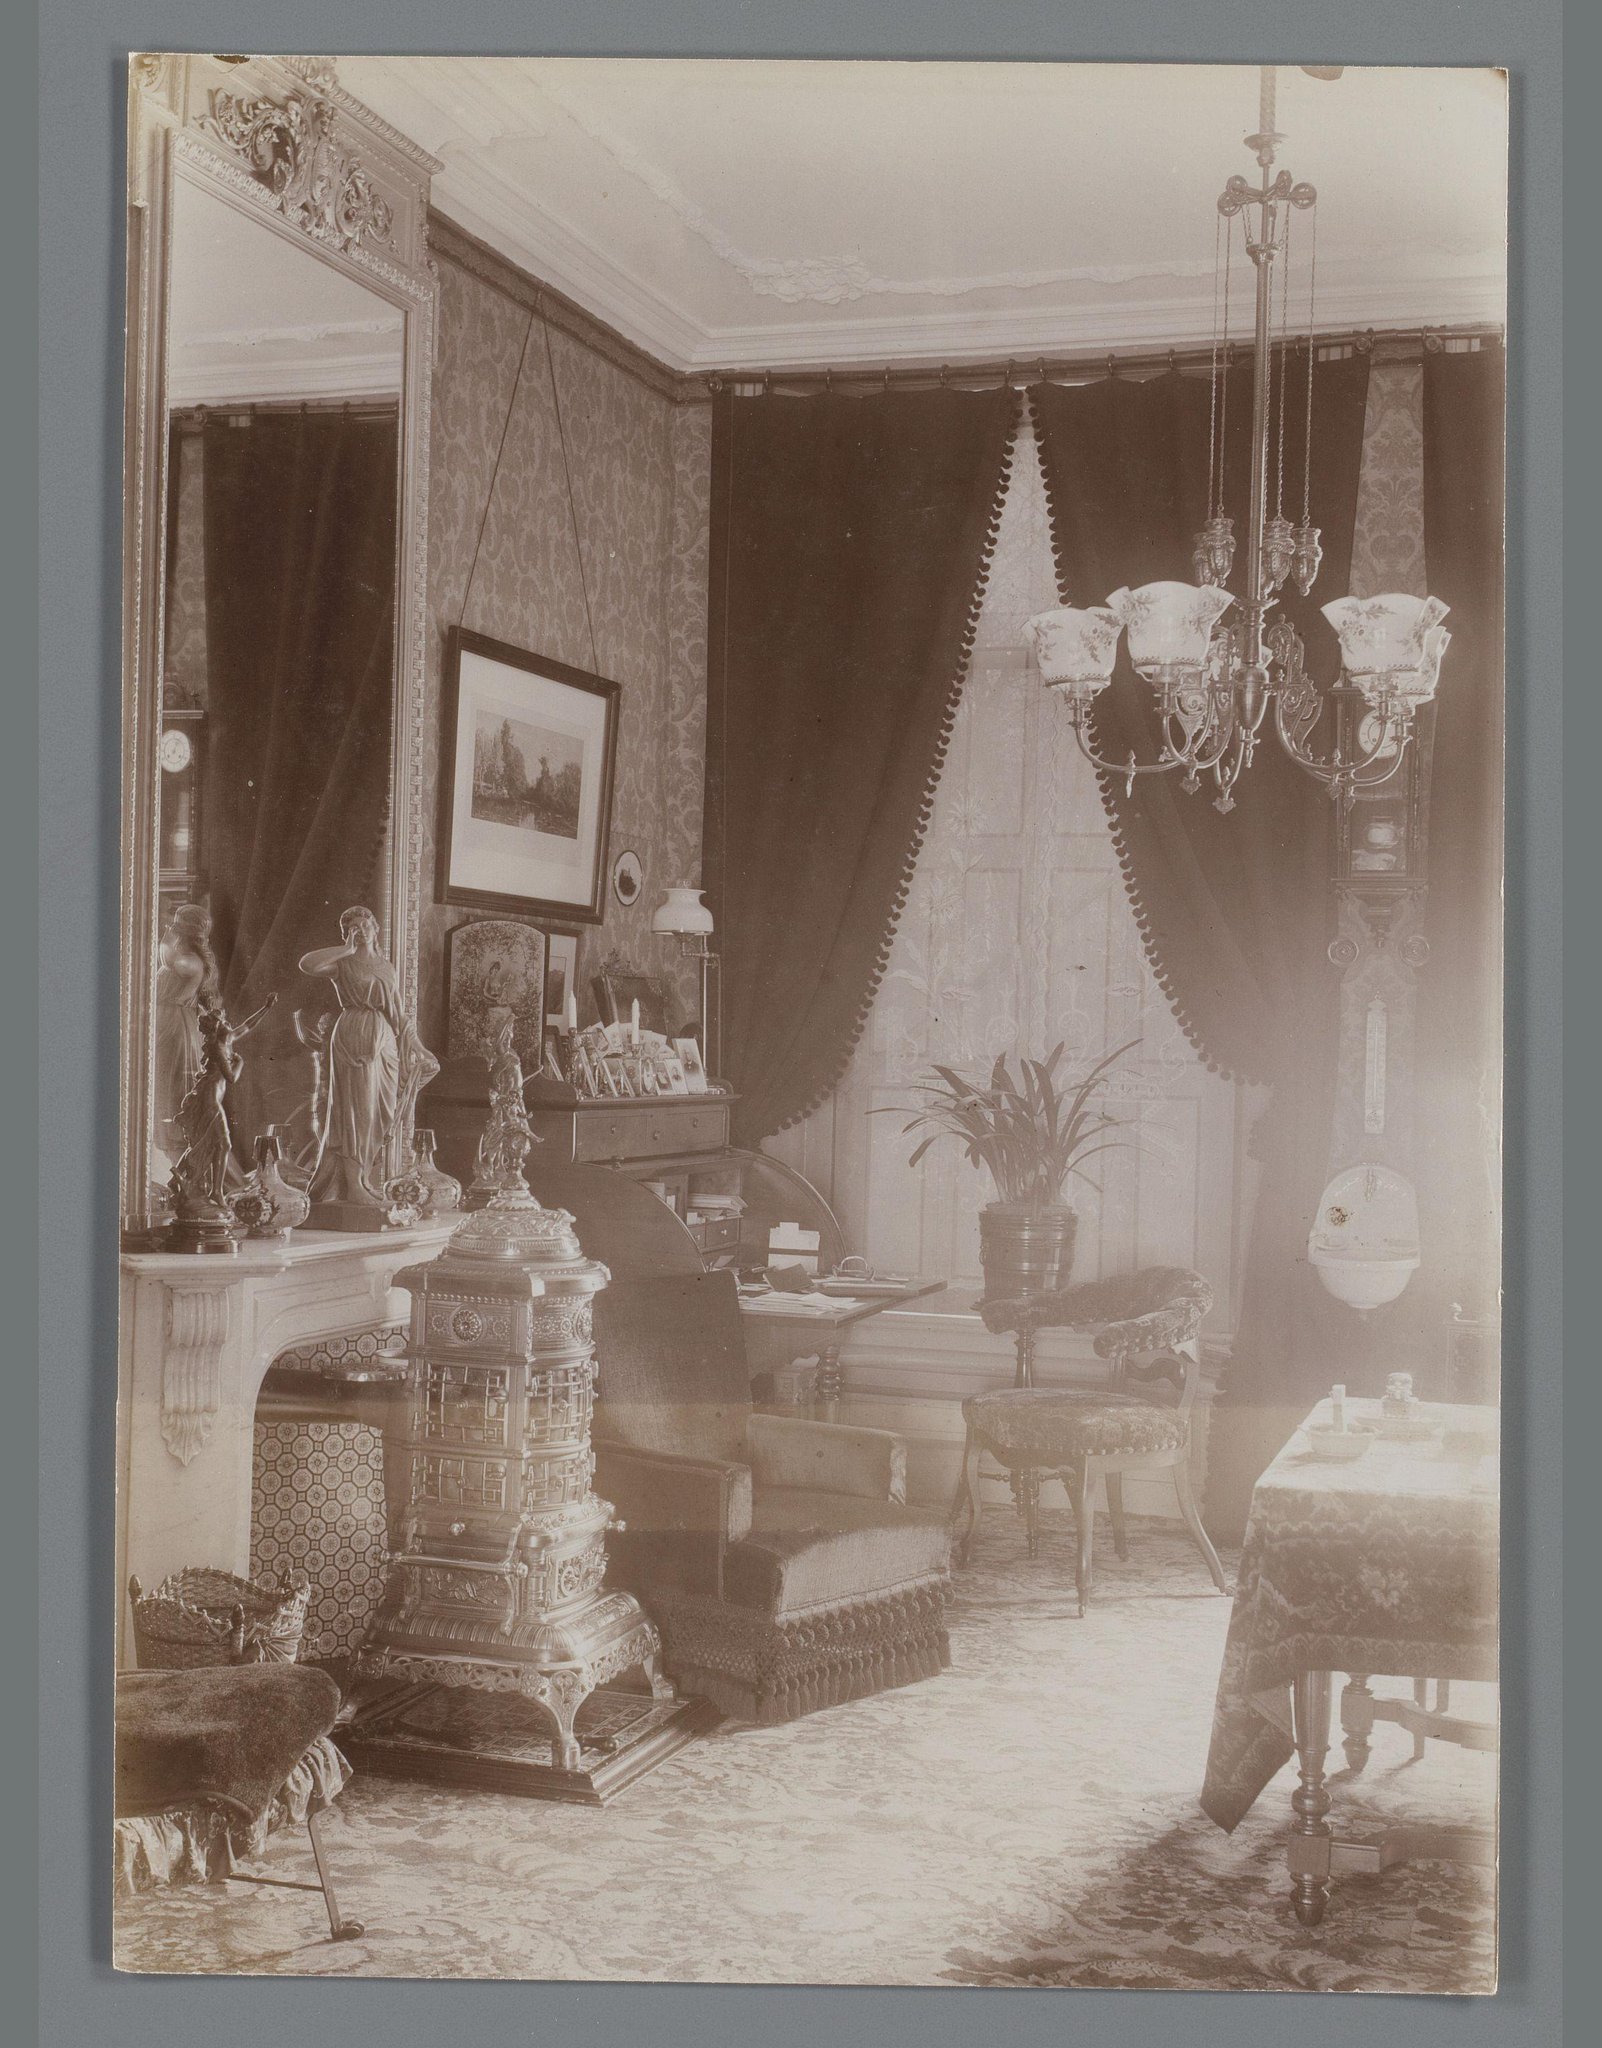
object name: photograph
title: Interieur met secretaire van het huis van Piet de Jong in Arnhem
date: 1900-1917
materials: paper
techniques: collodion silver print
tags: interior of the house